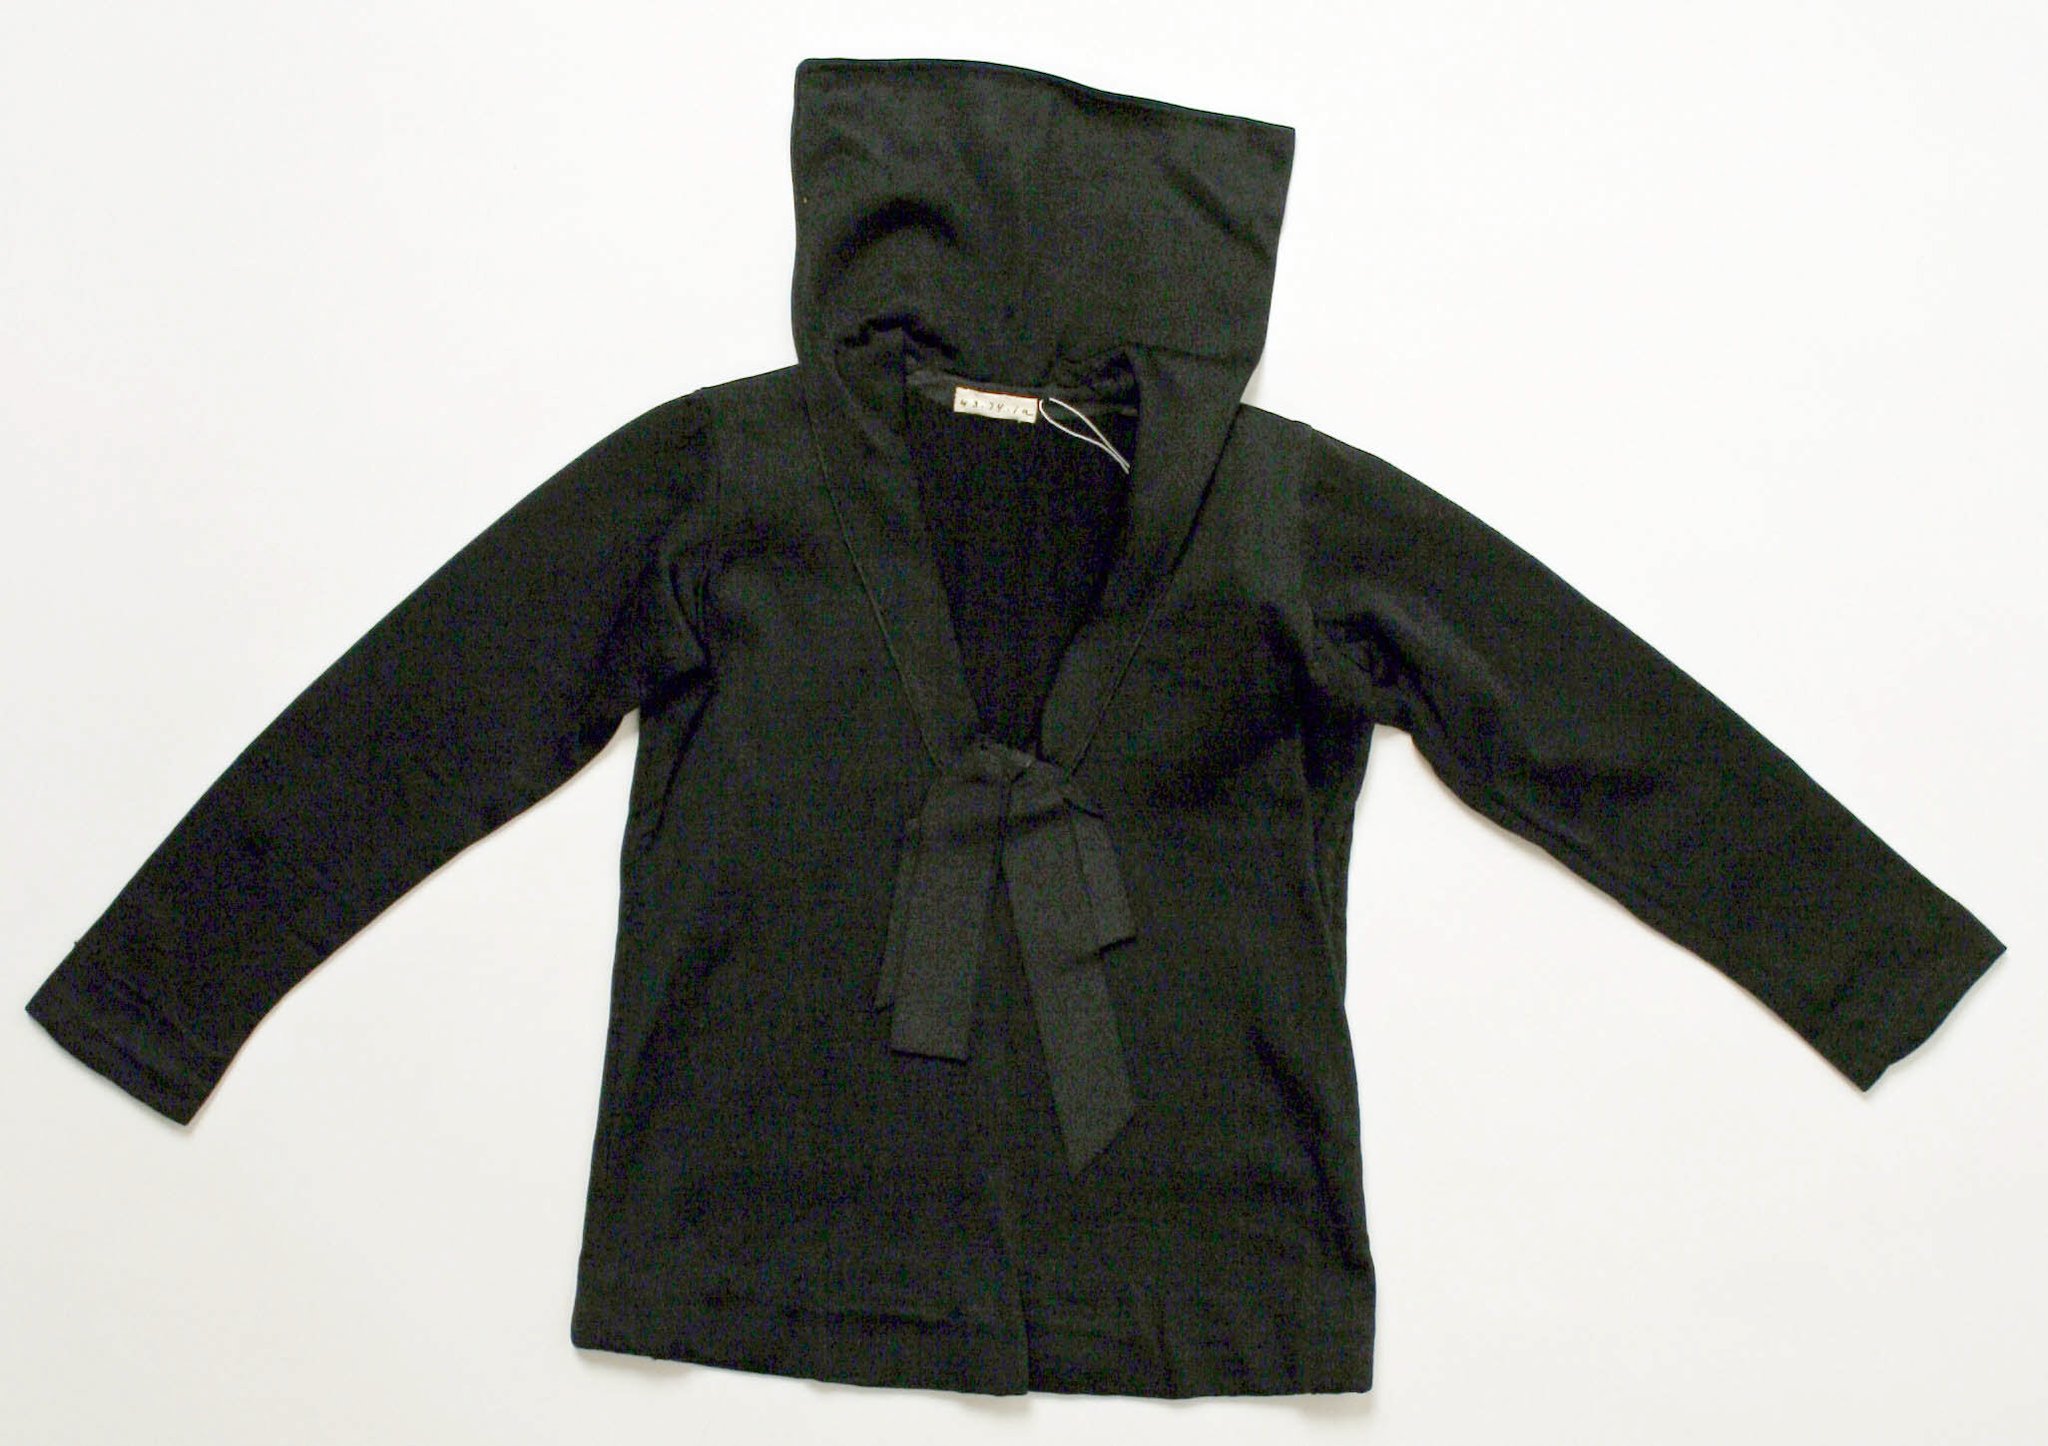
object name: suit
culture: american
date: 1880-1889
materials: silk